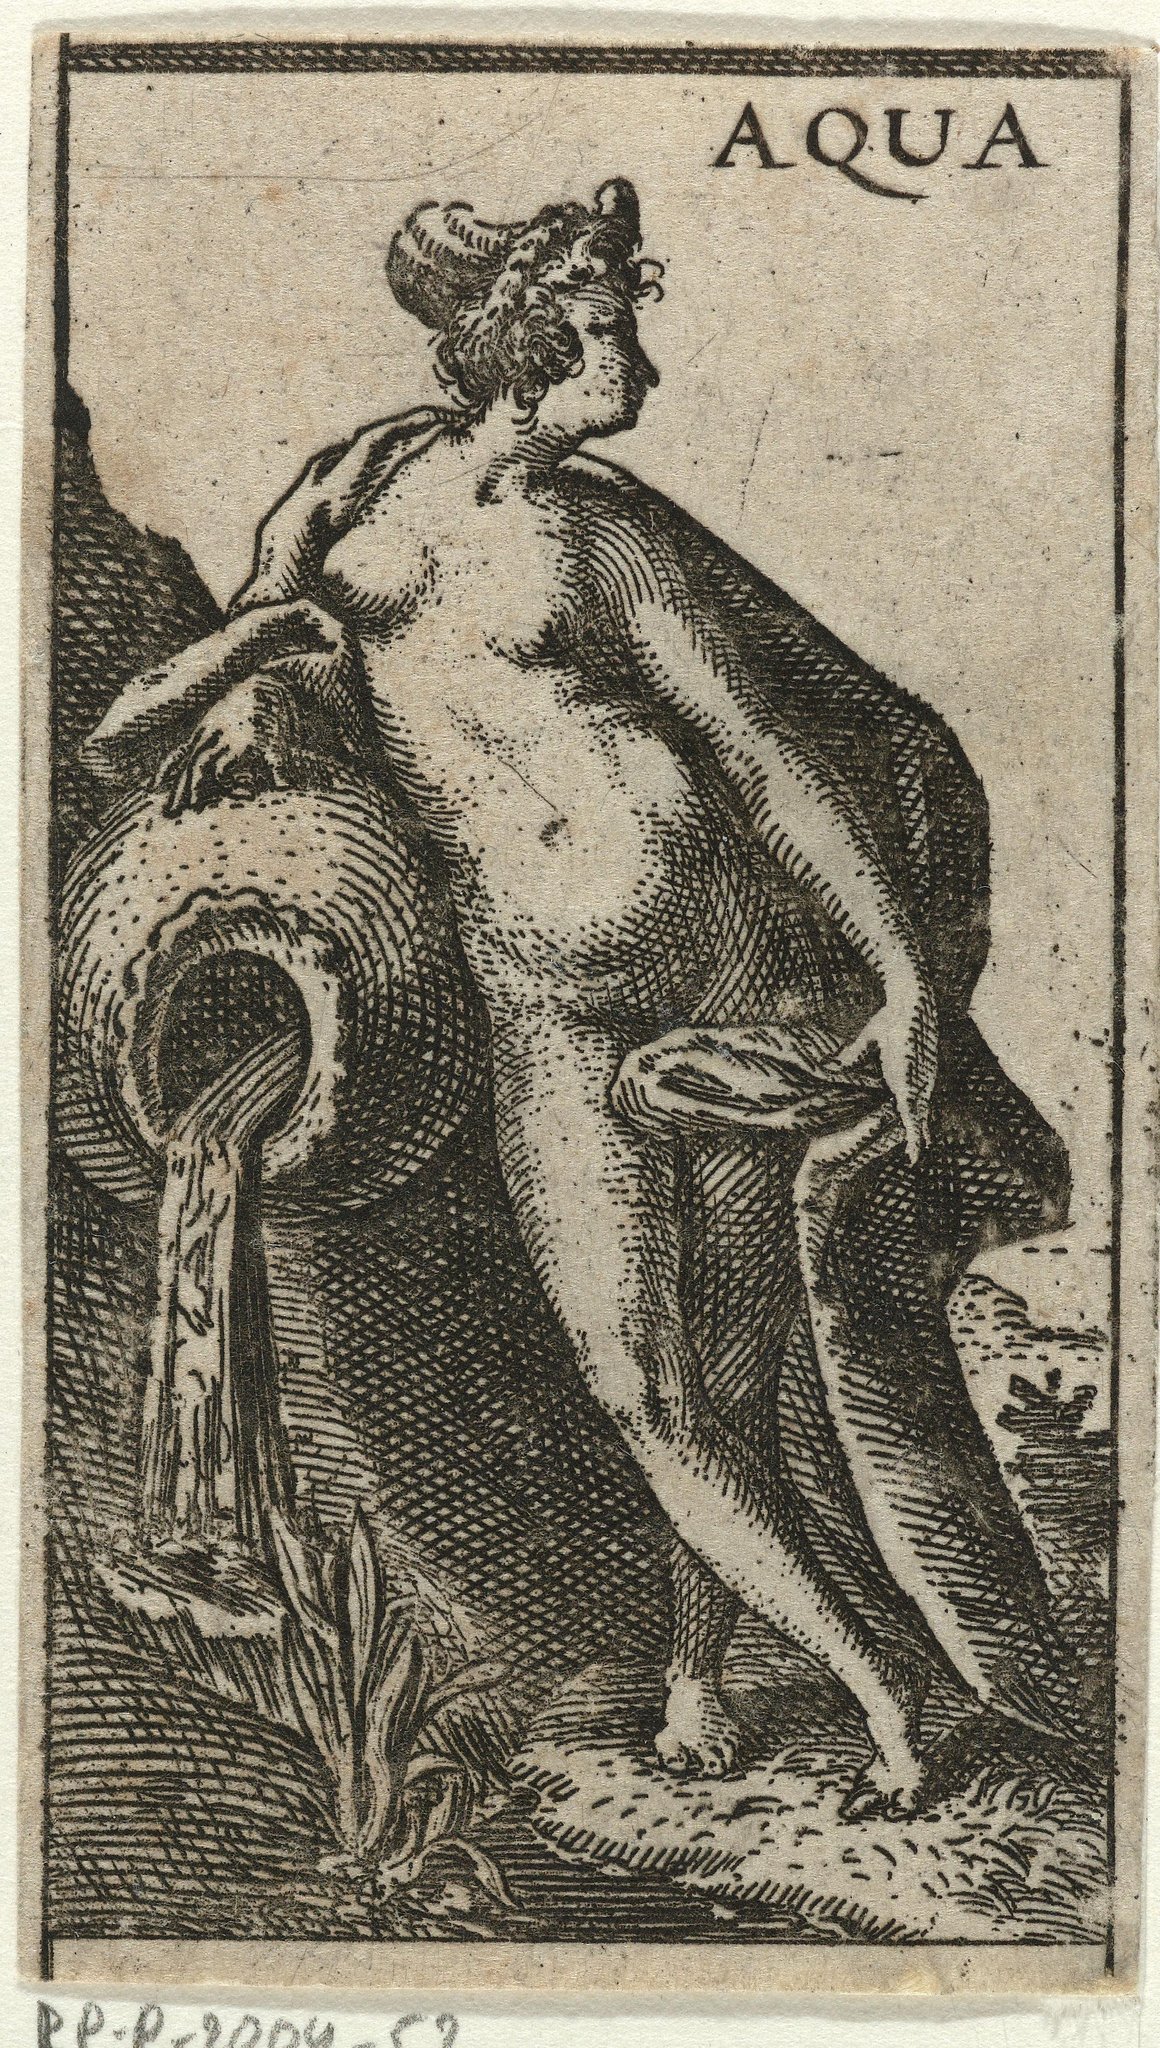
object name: print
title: De vier elementen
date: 1606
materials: paper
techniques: engraving, etching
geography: amsterdam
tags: 'acqua', 'carro dell'acqua' (ripa)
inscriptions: collector's mark: Lugt 2228, collector's mark: Lugt 2760, title: ‘AQUA’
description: Personificatie van water, een van de vier elementen, als een naakte vrouw leunend op grote waterkruik.